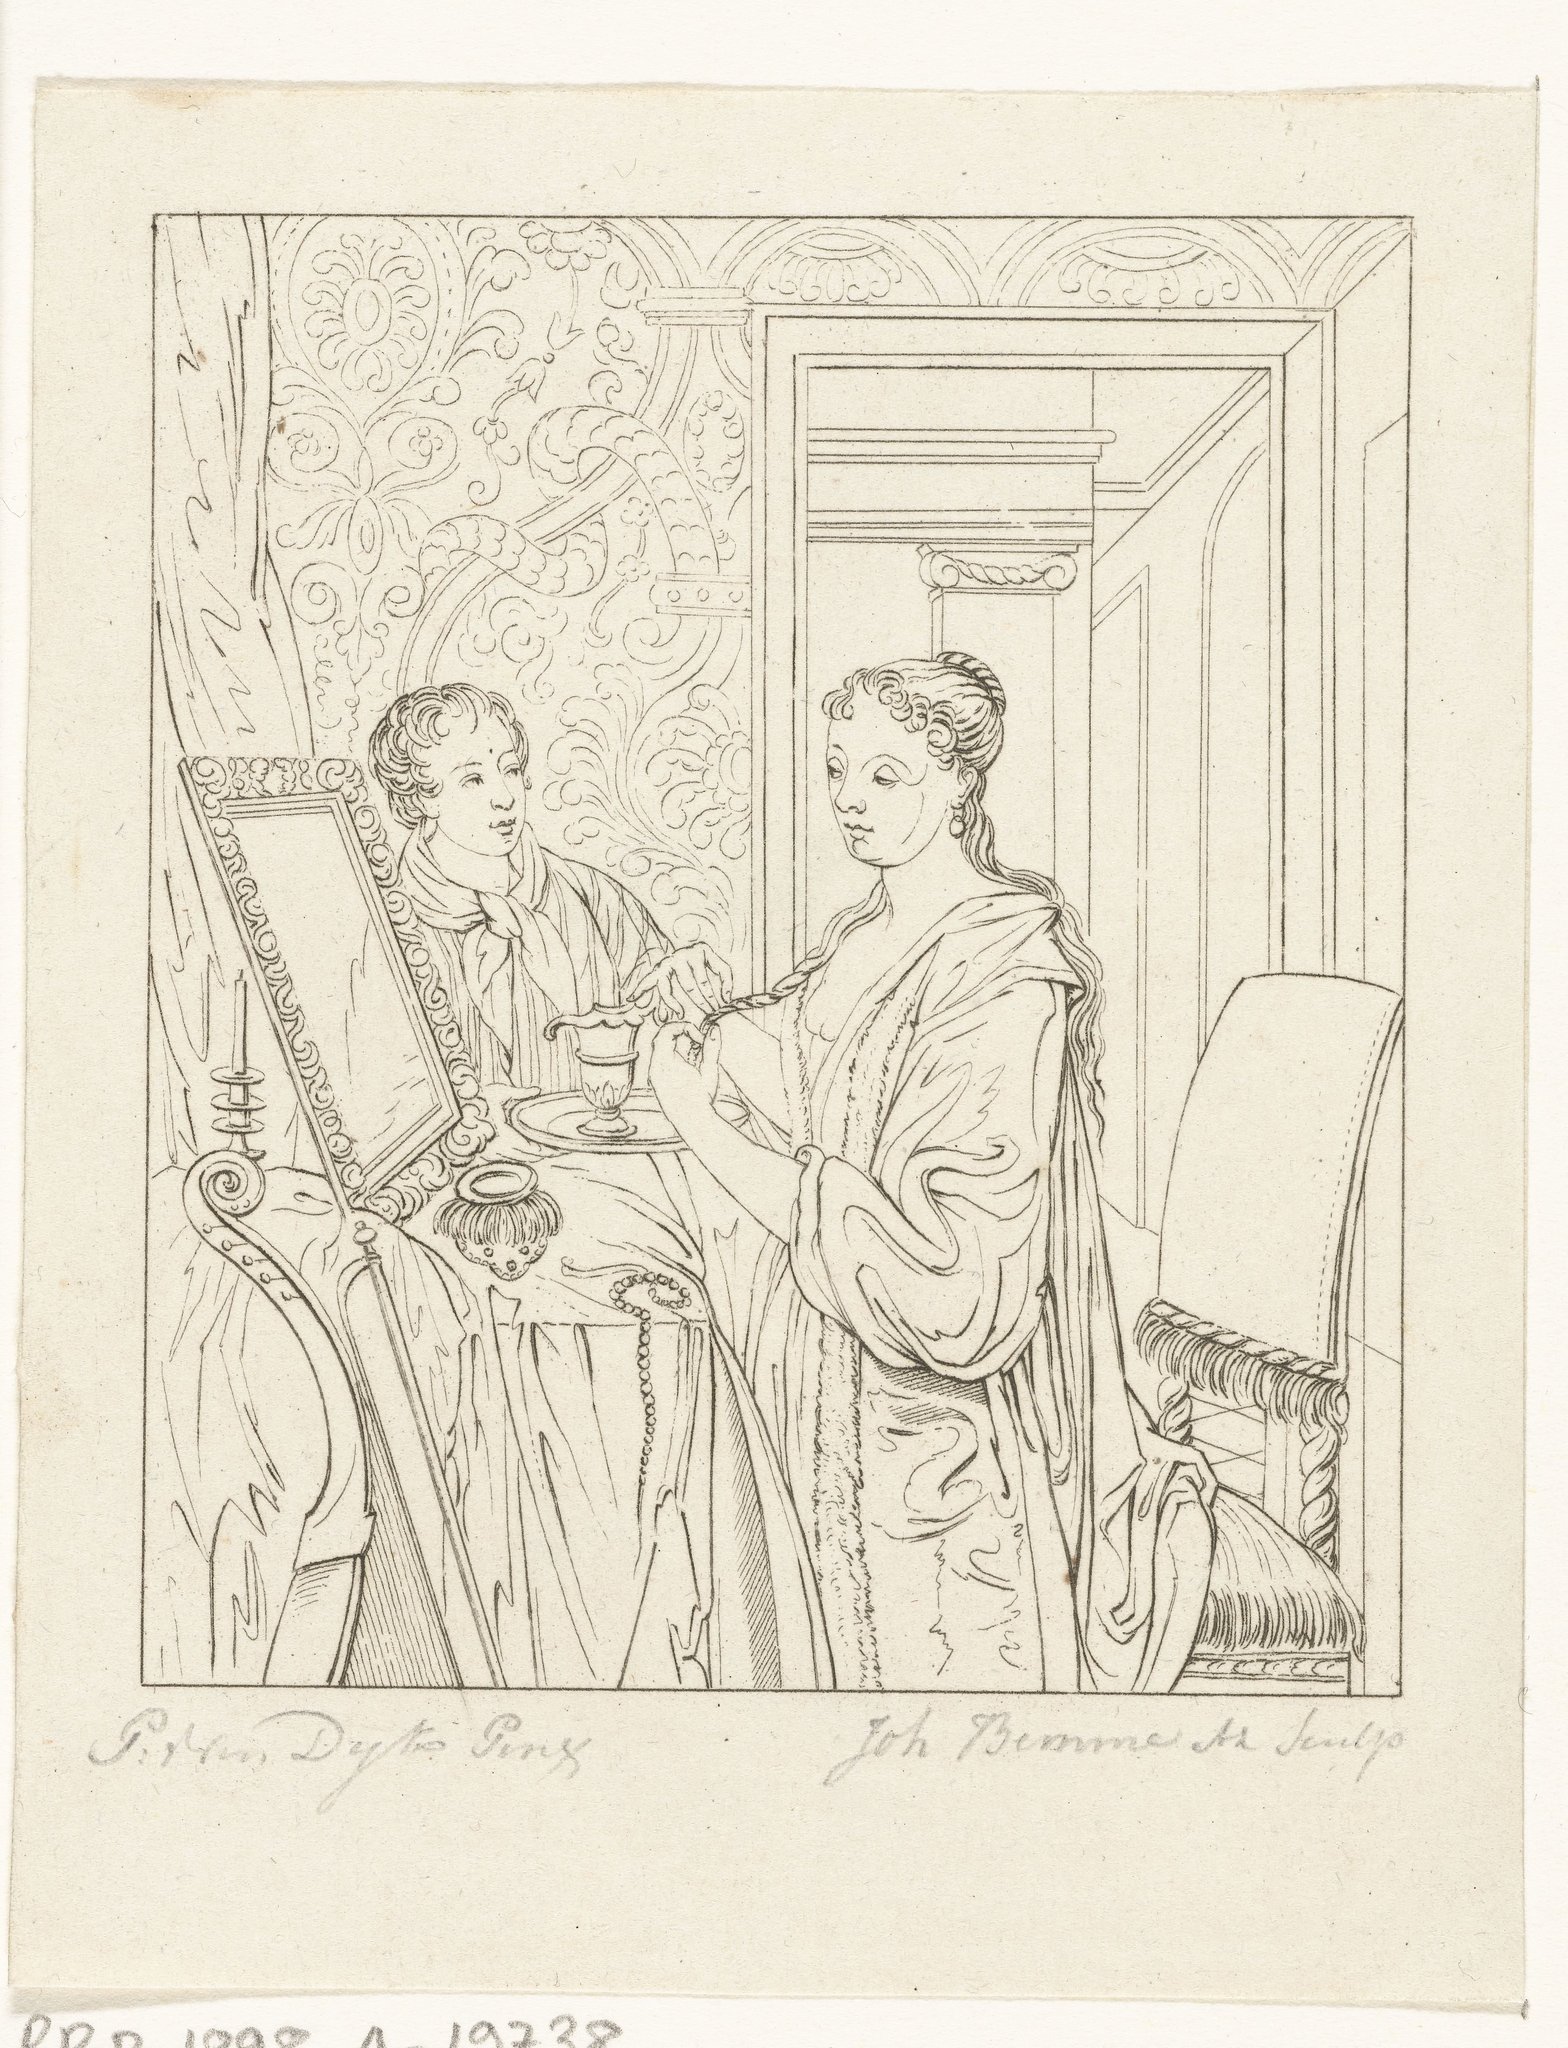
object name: print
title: Een vrouw bij haar toilet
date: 1800-1841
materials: paper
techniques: etching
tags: making toilet, looking in the mirror; contemplation of own beauty, servant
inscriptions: collector's mark: Lugt 2228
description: Een vrouw staat voor een spiegel en vlecht haar haren. Op de achtergrond komt een bediende met een dienblad waarop een karaaf staat. Links op de voorgrond is een snaarinstrument te zien.